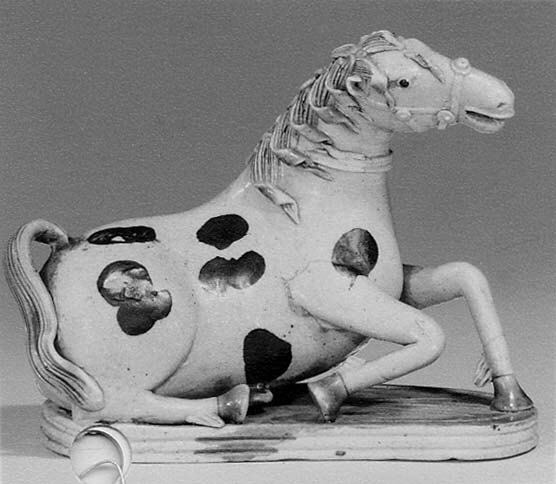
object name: figure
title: Figure of Horse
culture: chinese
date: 1667-1733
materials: biscuit, enamel, porcelain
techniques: painting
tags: horses